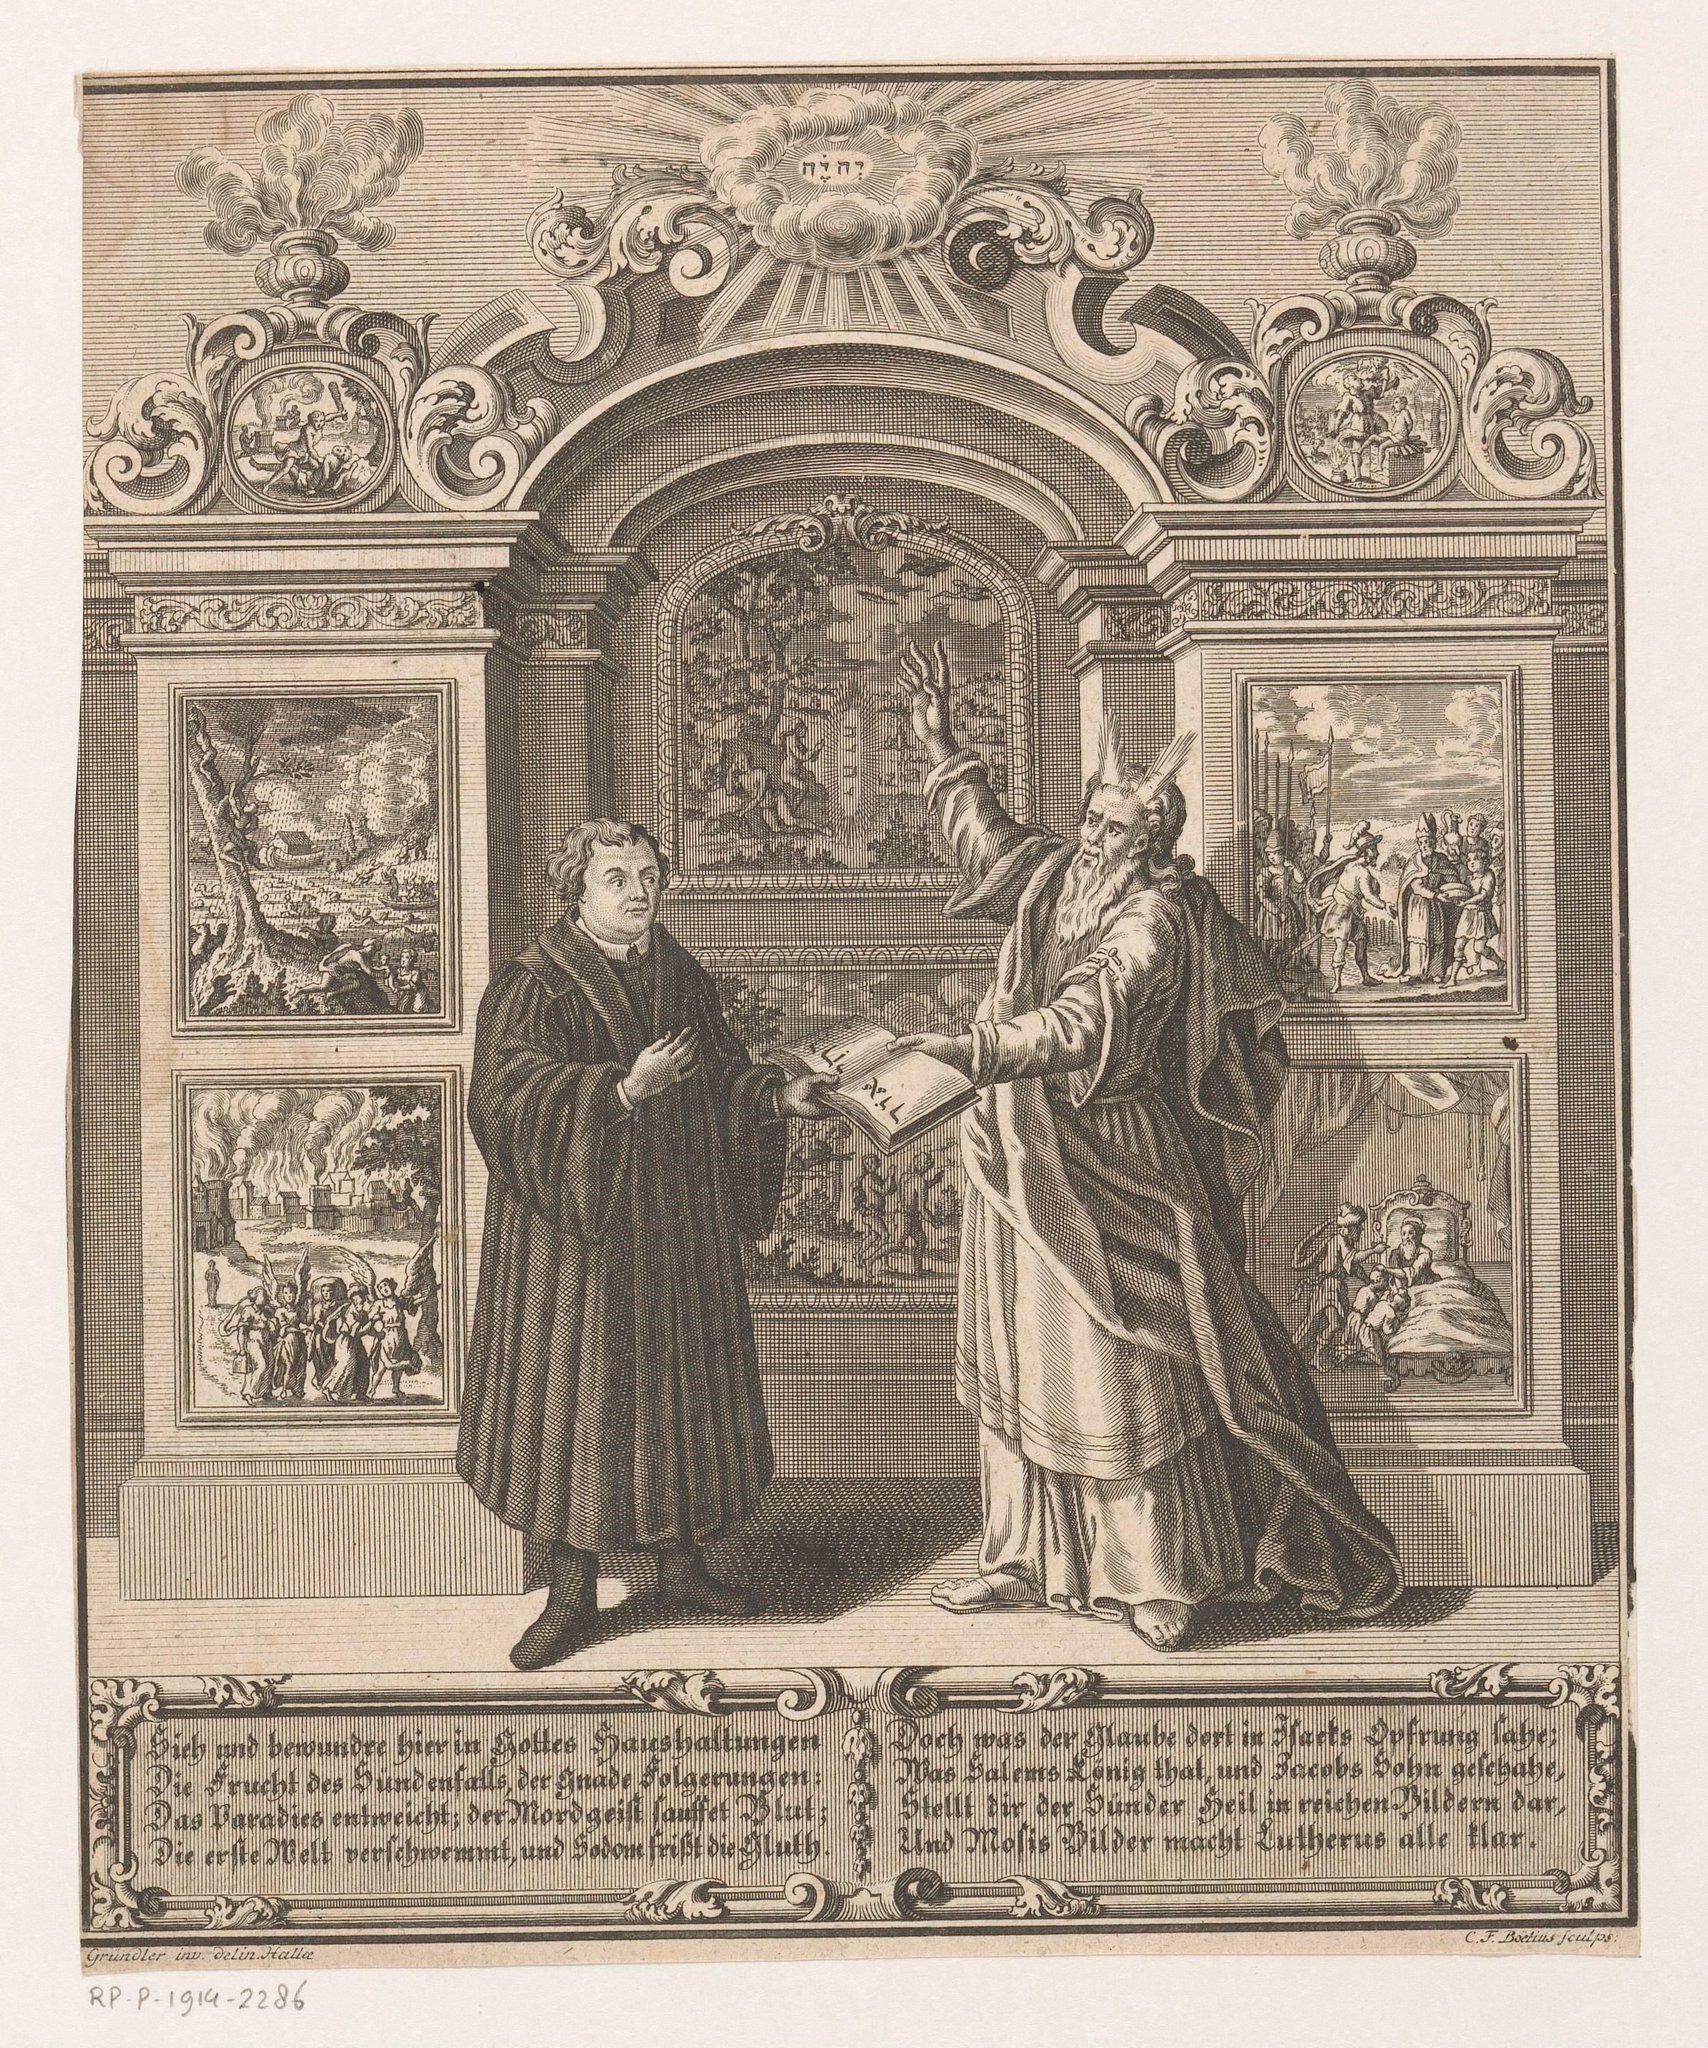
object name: print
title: Allegorische voorstelling met Martin Luther en Mozes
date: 1733-1782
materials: paper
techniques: engraving, etching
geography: halle an der saale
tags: priest, martin luther, the killing of abel: cain slays him with a stone, a club or a jaw-bone, alternatively with a spade or another tool as weapon, the sacrifice of isaac (genesis 22), historical persons, moses teaching (in general), expulsion of adam and eve from paradise (genesis 3:22-24), genesis: the story of joseph, story of noah, sodom and gomorrah burning, the bible as a book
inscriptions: collector's mark: Lugt 2228